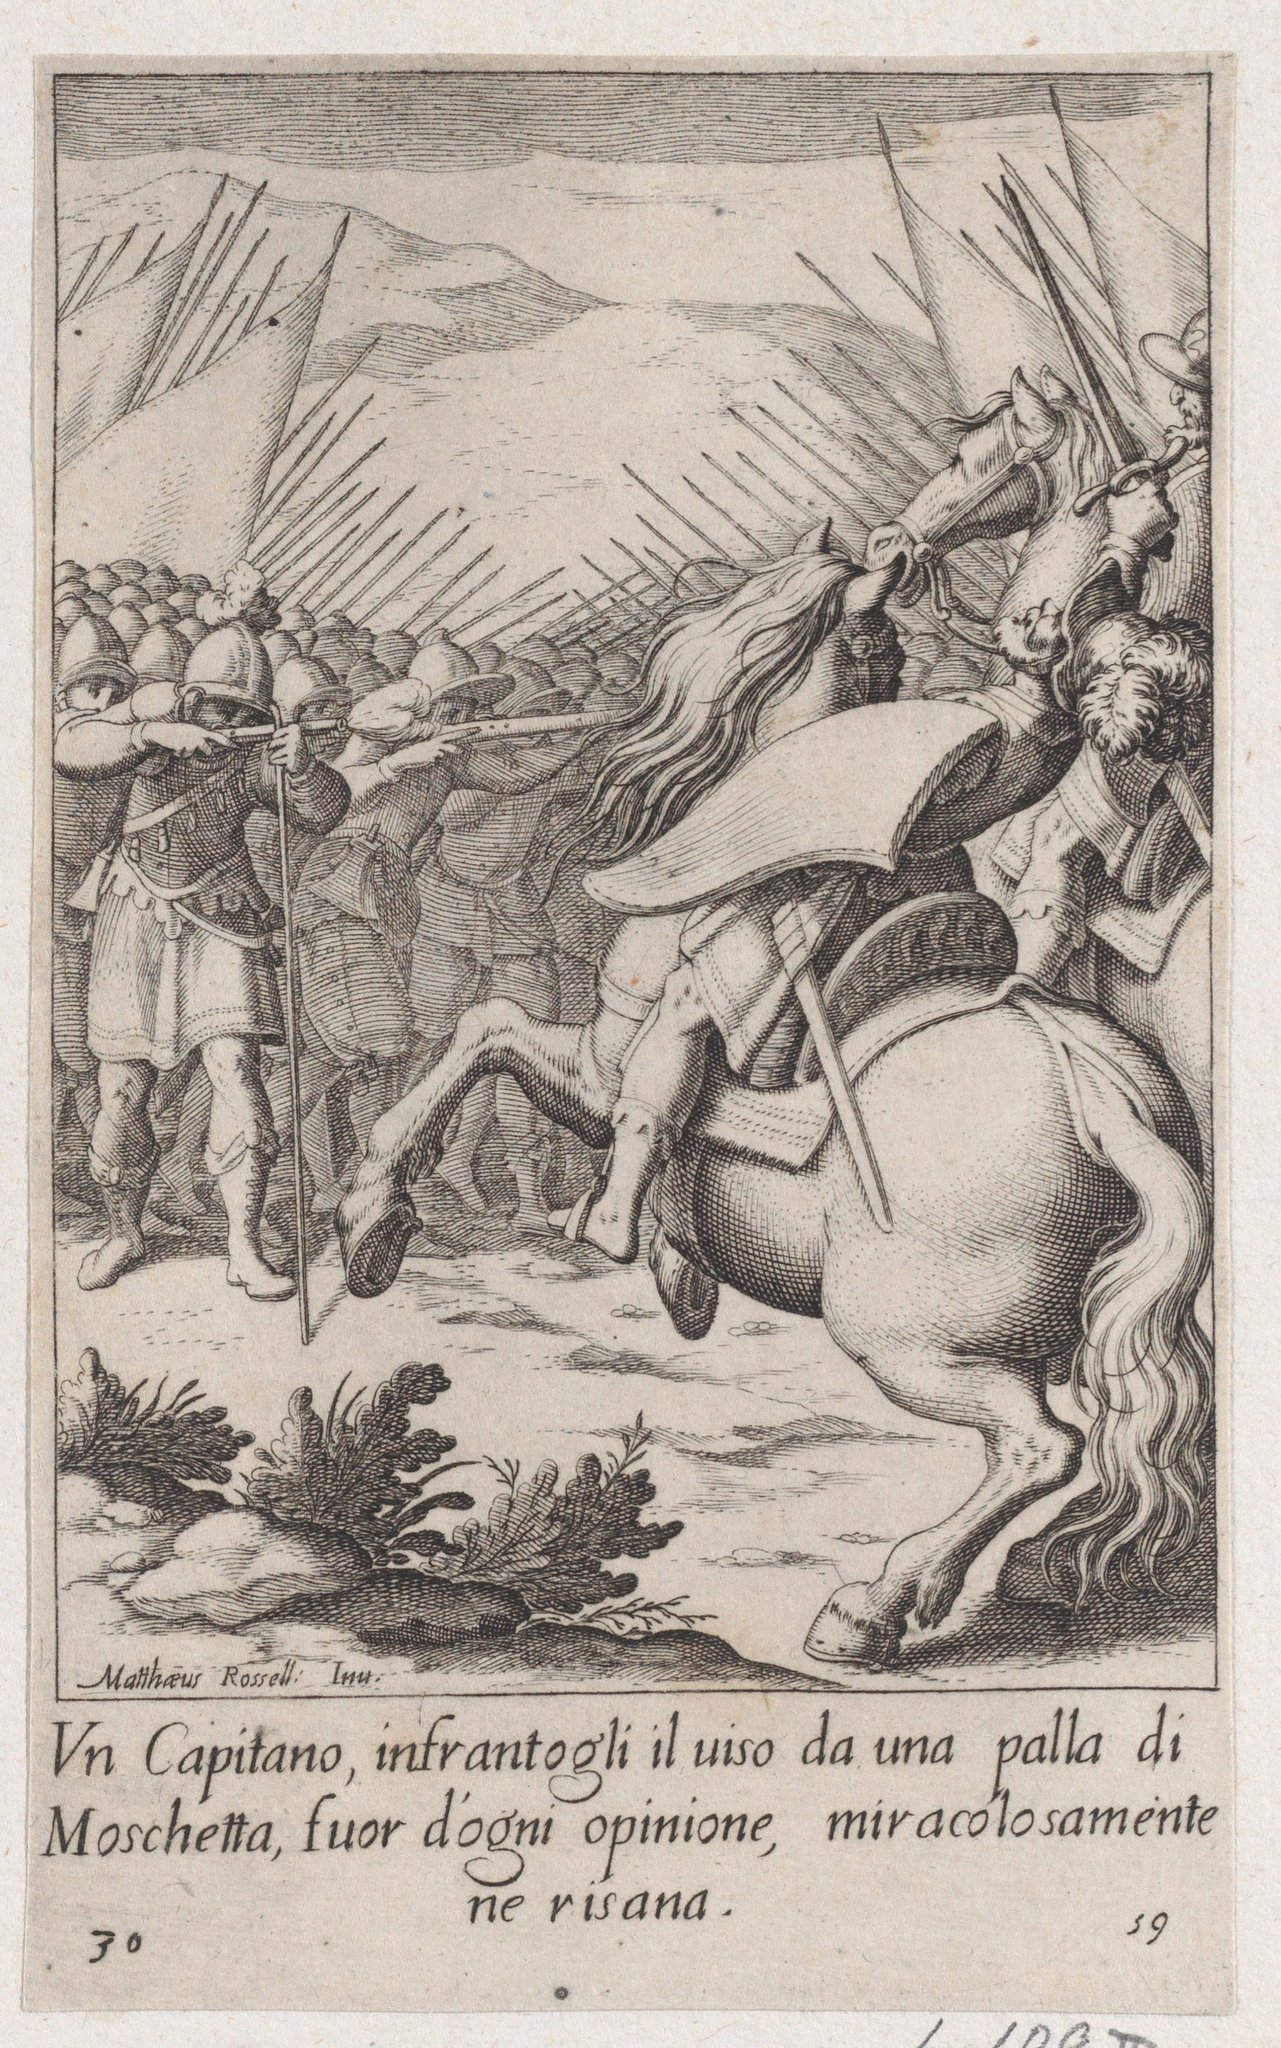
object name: print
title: The Captain, from Scelta d'Alcuni Miracoli e Grazie della Santissima Nunziata di Firenze (Selection of Some Miracles and Graces that Occurred in the Church of the Annunziata in Florence)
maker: jacques callot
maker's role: artist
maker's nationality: french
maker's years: 1592-1635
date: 1611-1619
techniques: engraving